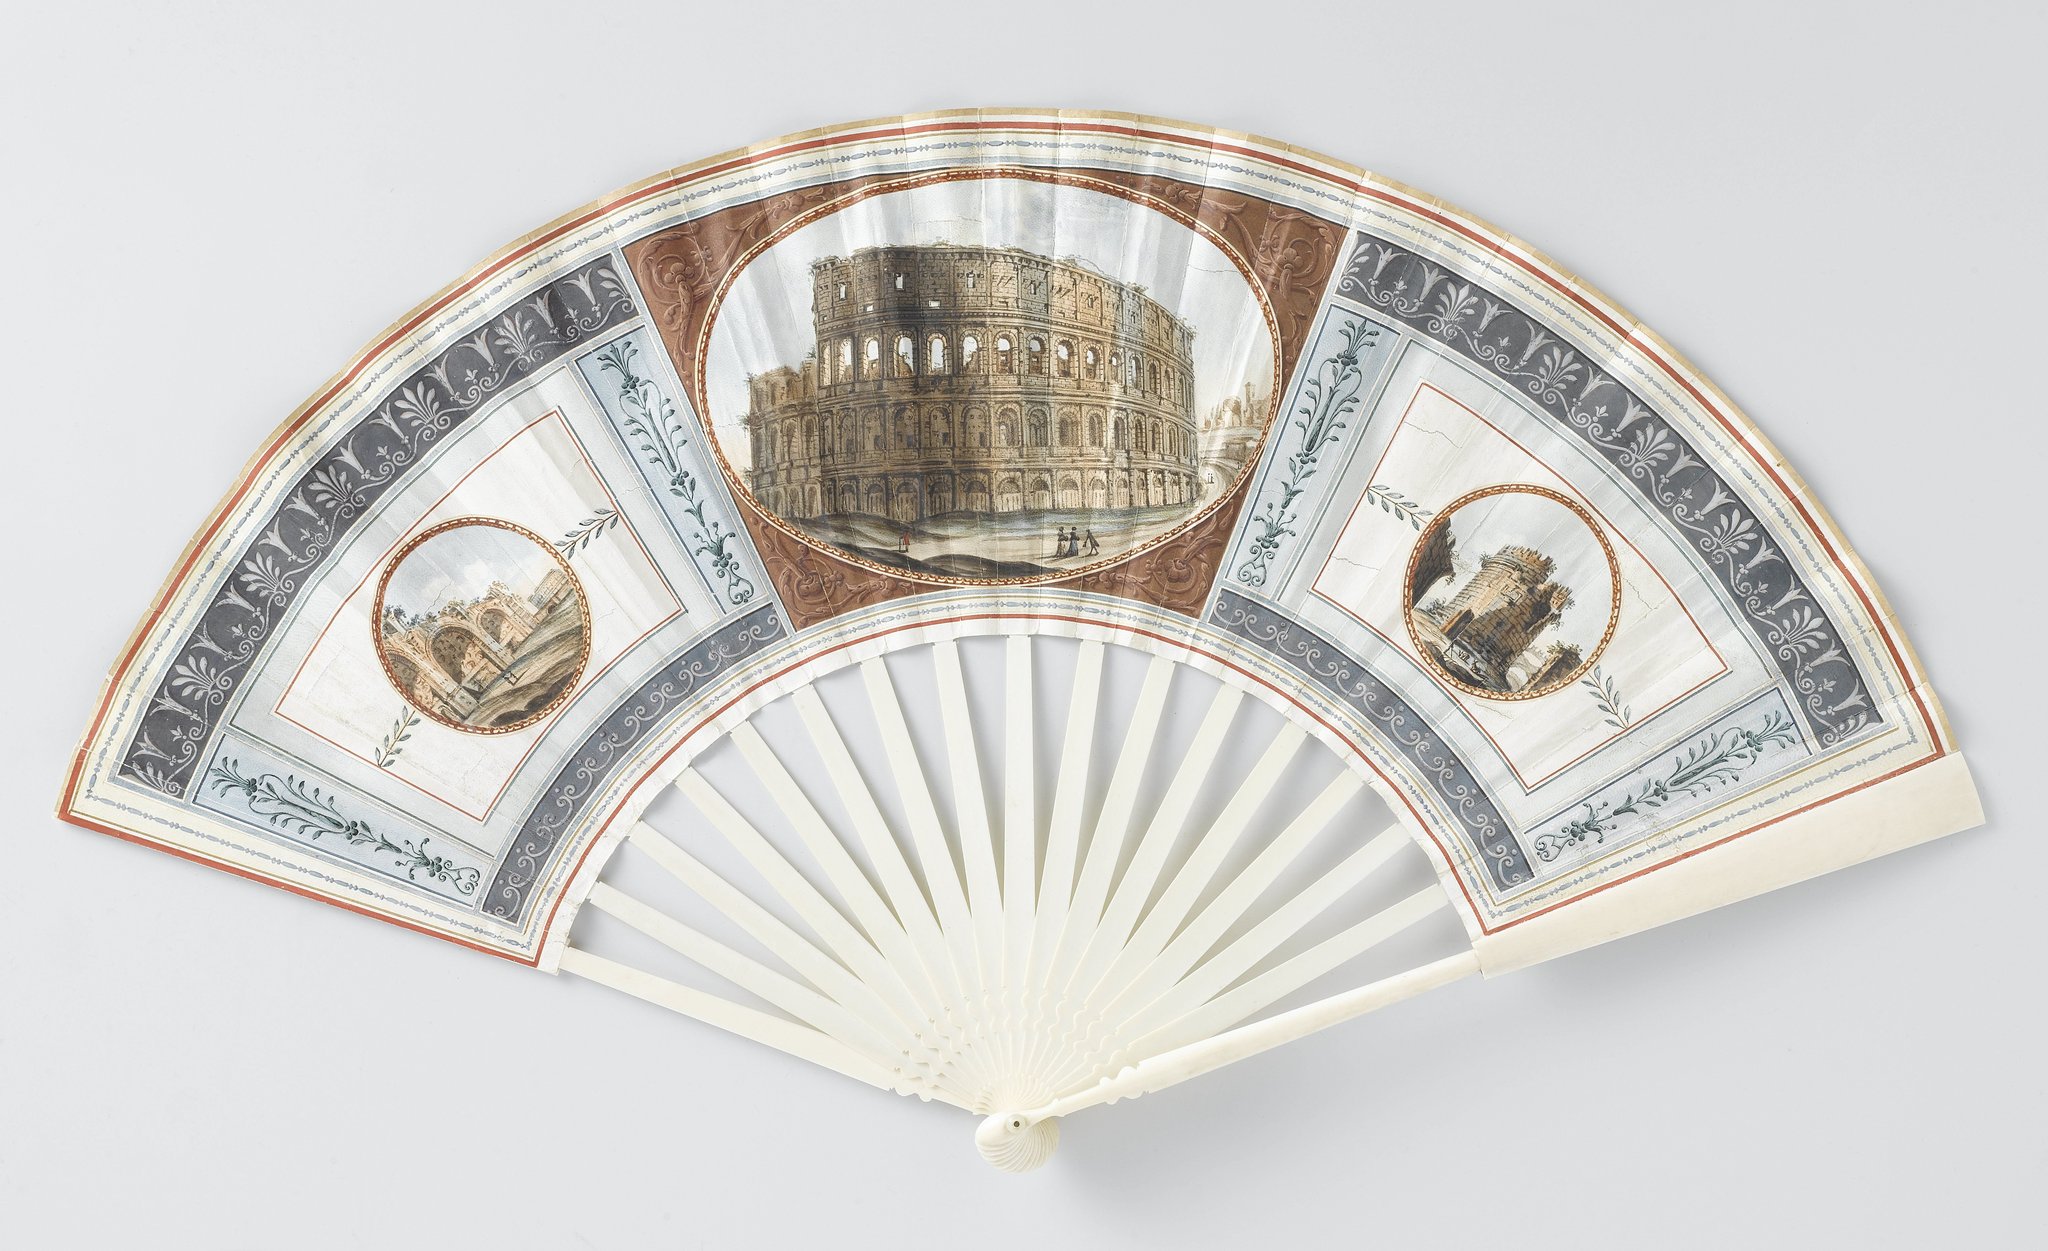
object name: vouwwaaier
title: Vouwwaaier met blad van geitenleer, waarop met gouache het Colosseum, de thermen van Caracalla (l) en de Tombe van Caecilia Metella (r), op ivoren montuur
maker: camillo buti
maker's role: painter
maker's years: 1747-1808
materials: leather, gouache, ivory, metal, mother of pearl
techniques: cutting, painted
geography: rome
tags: rome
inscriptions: signature and date: ‘Camillo Buti Roma 1787’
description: Deze schilder/architect was in 1778 bekend geworden door een aantal prenten met afbeeldingen van wandschilderingen uit de in 1777 ontdekte Romeinse Villa Negroni, die hij samen met zijn vriend Raphael Mengs, de schilder Anton von Maron (een leerling van Mengs) en de graveur Angelo Campanella had uitgegeven. Deze prenten vormden het begin van een serie, die pas in 1802 voltooid zou worden. Ze vonden gretig aftrek bij Nederlandse bezoekers: Hendrik Fagel betaald in 1786 10 zecchini voor een aantal. Eenmaal bij Buti, kochten hij en zijn oom Jacob Boreel ieder ook nog een waaier. (Voor Fagel en Boreel bij Buti zie, R. de Leeuw (ed.), Herinneringen aan Italië..., Zwolle 1984, pp. 26-7, 33, 173). Al vanaf de 17de eeuw, maar met name in de tweede helft van de 18de eeuw maakten veel welgestelde, jonge Nederlanders ter afsluiting van hun opvoeding een 'Grand Tour'. Een belangrijk onderdeel hierin vormde de reis door Italië, waarvan men graag een of meerdere souvenirs mee naar huis nam. Het werd de toerist in reisgidsen aangeraden vooral tekeningen en prenten met 'veduten' te kopen. In Rome kwam men sinds het einde van de jaren 1770 dan al snel terecht bij Camillo Buti (1747-1808).